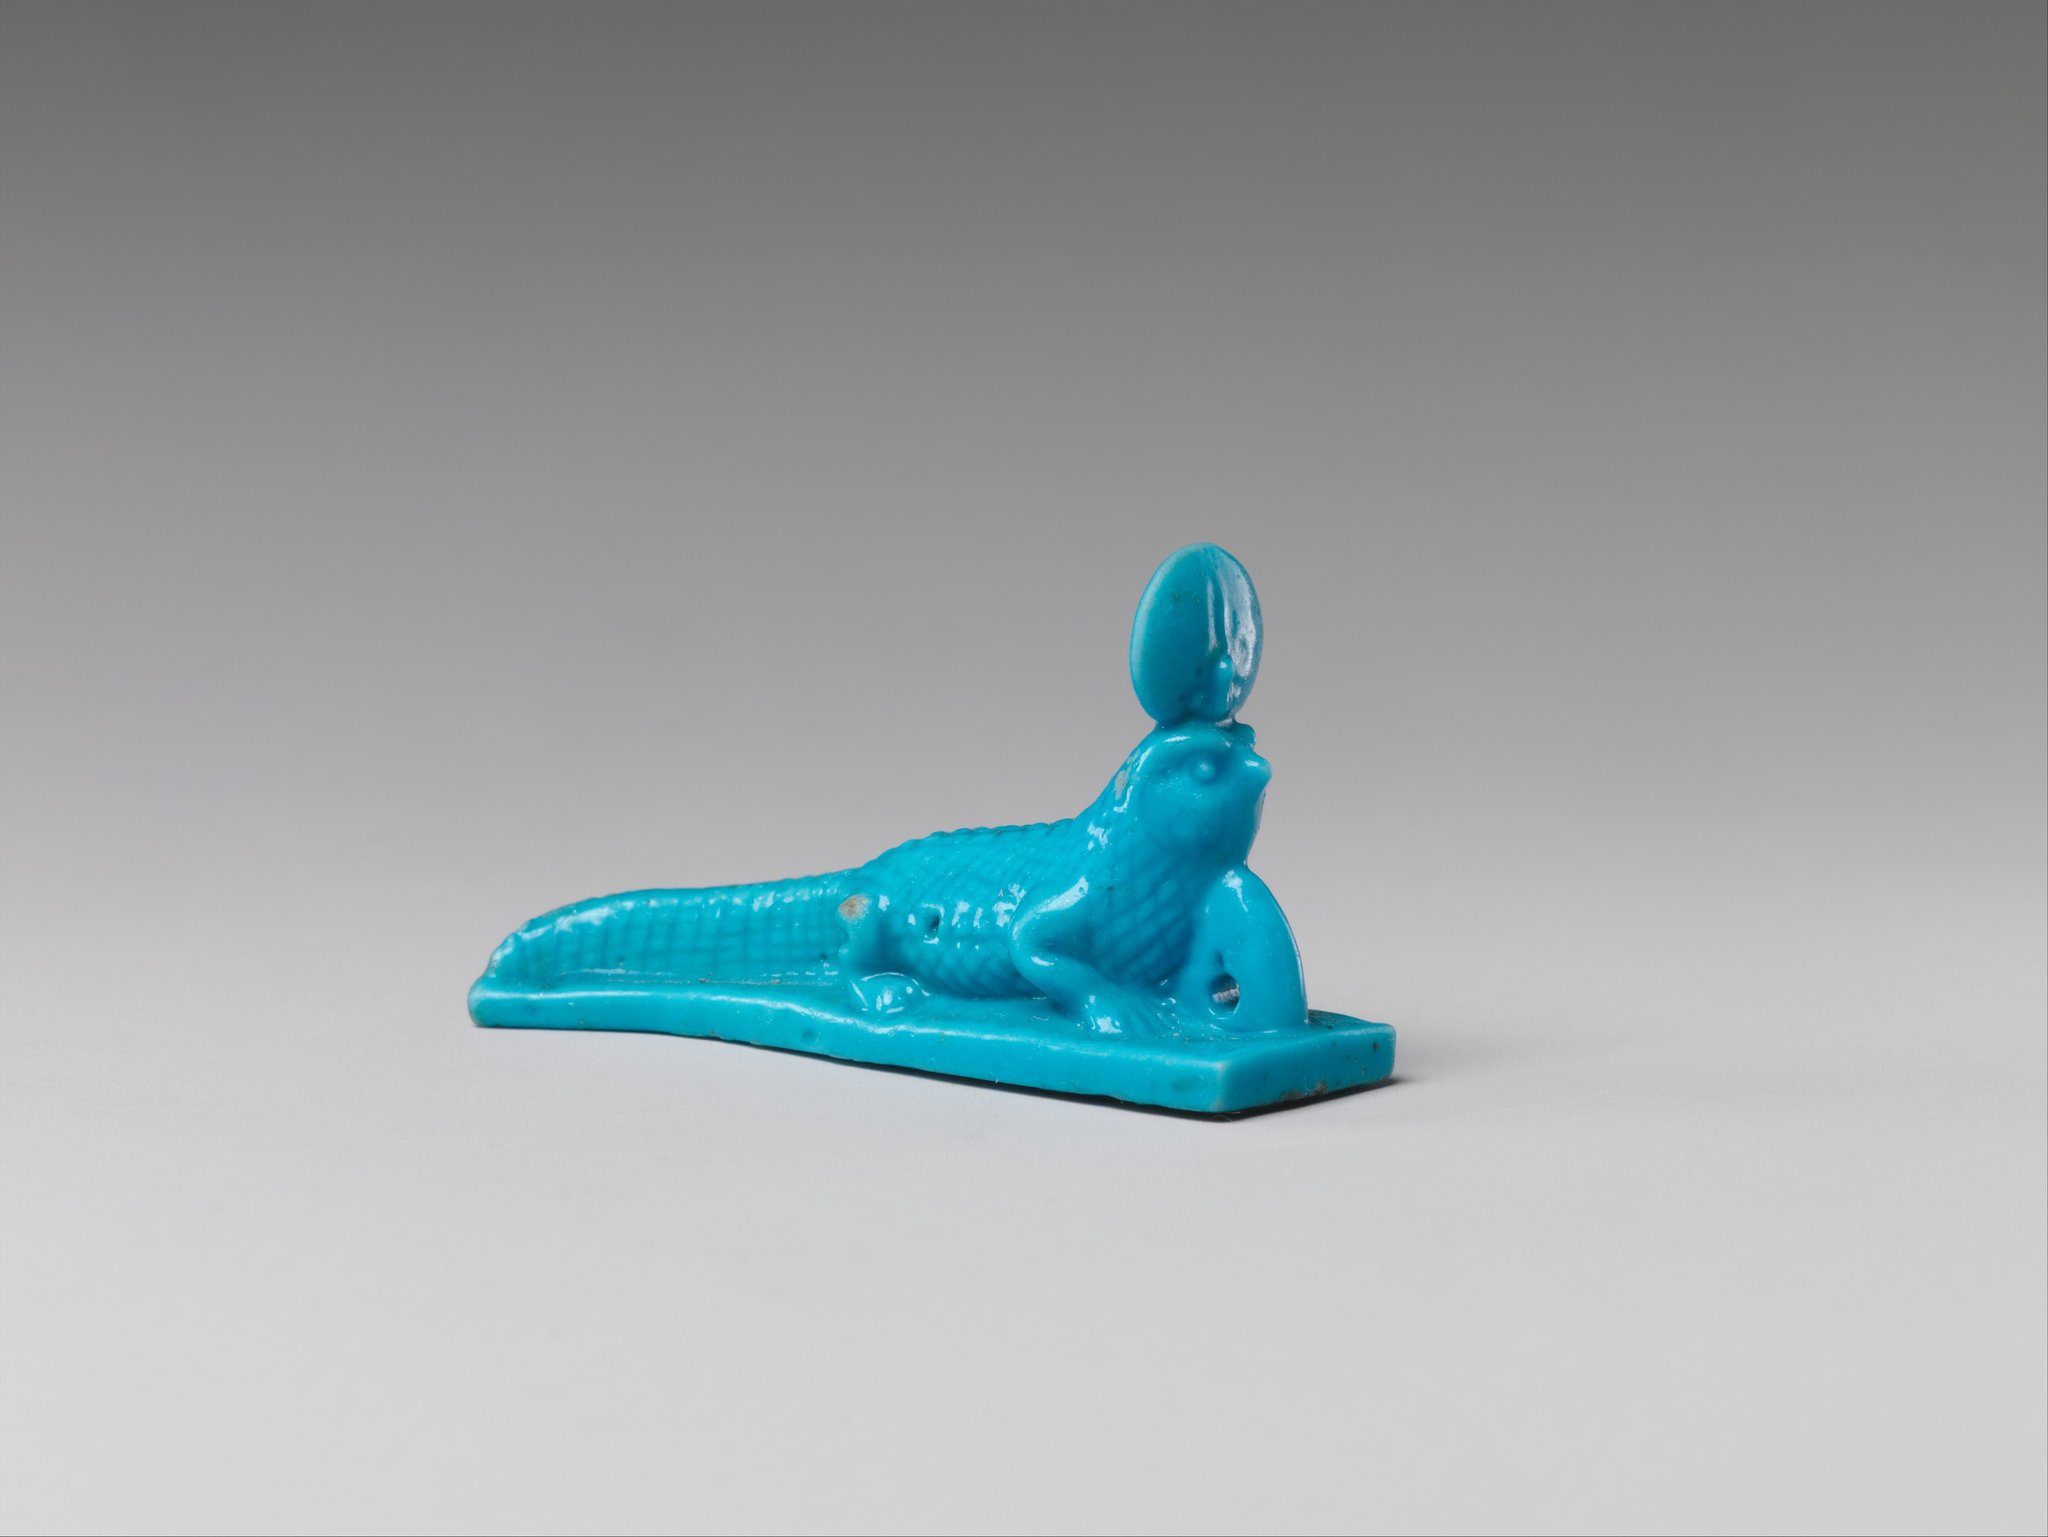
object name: amulet, falcon headed crocodile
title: Falcon-headed crocodile amulet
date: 664-630 BCE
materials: faience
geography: egypt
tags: falcons,crocodiles